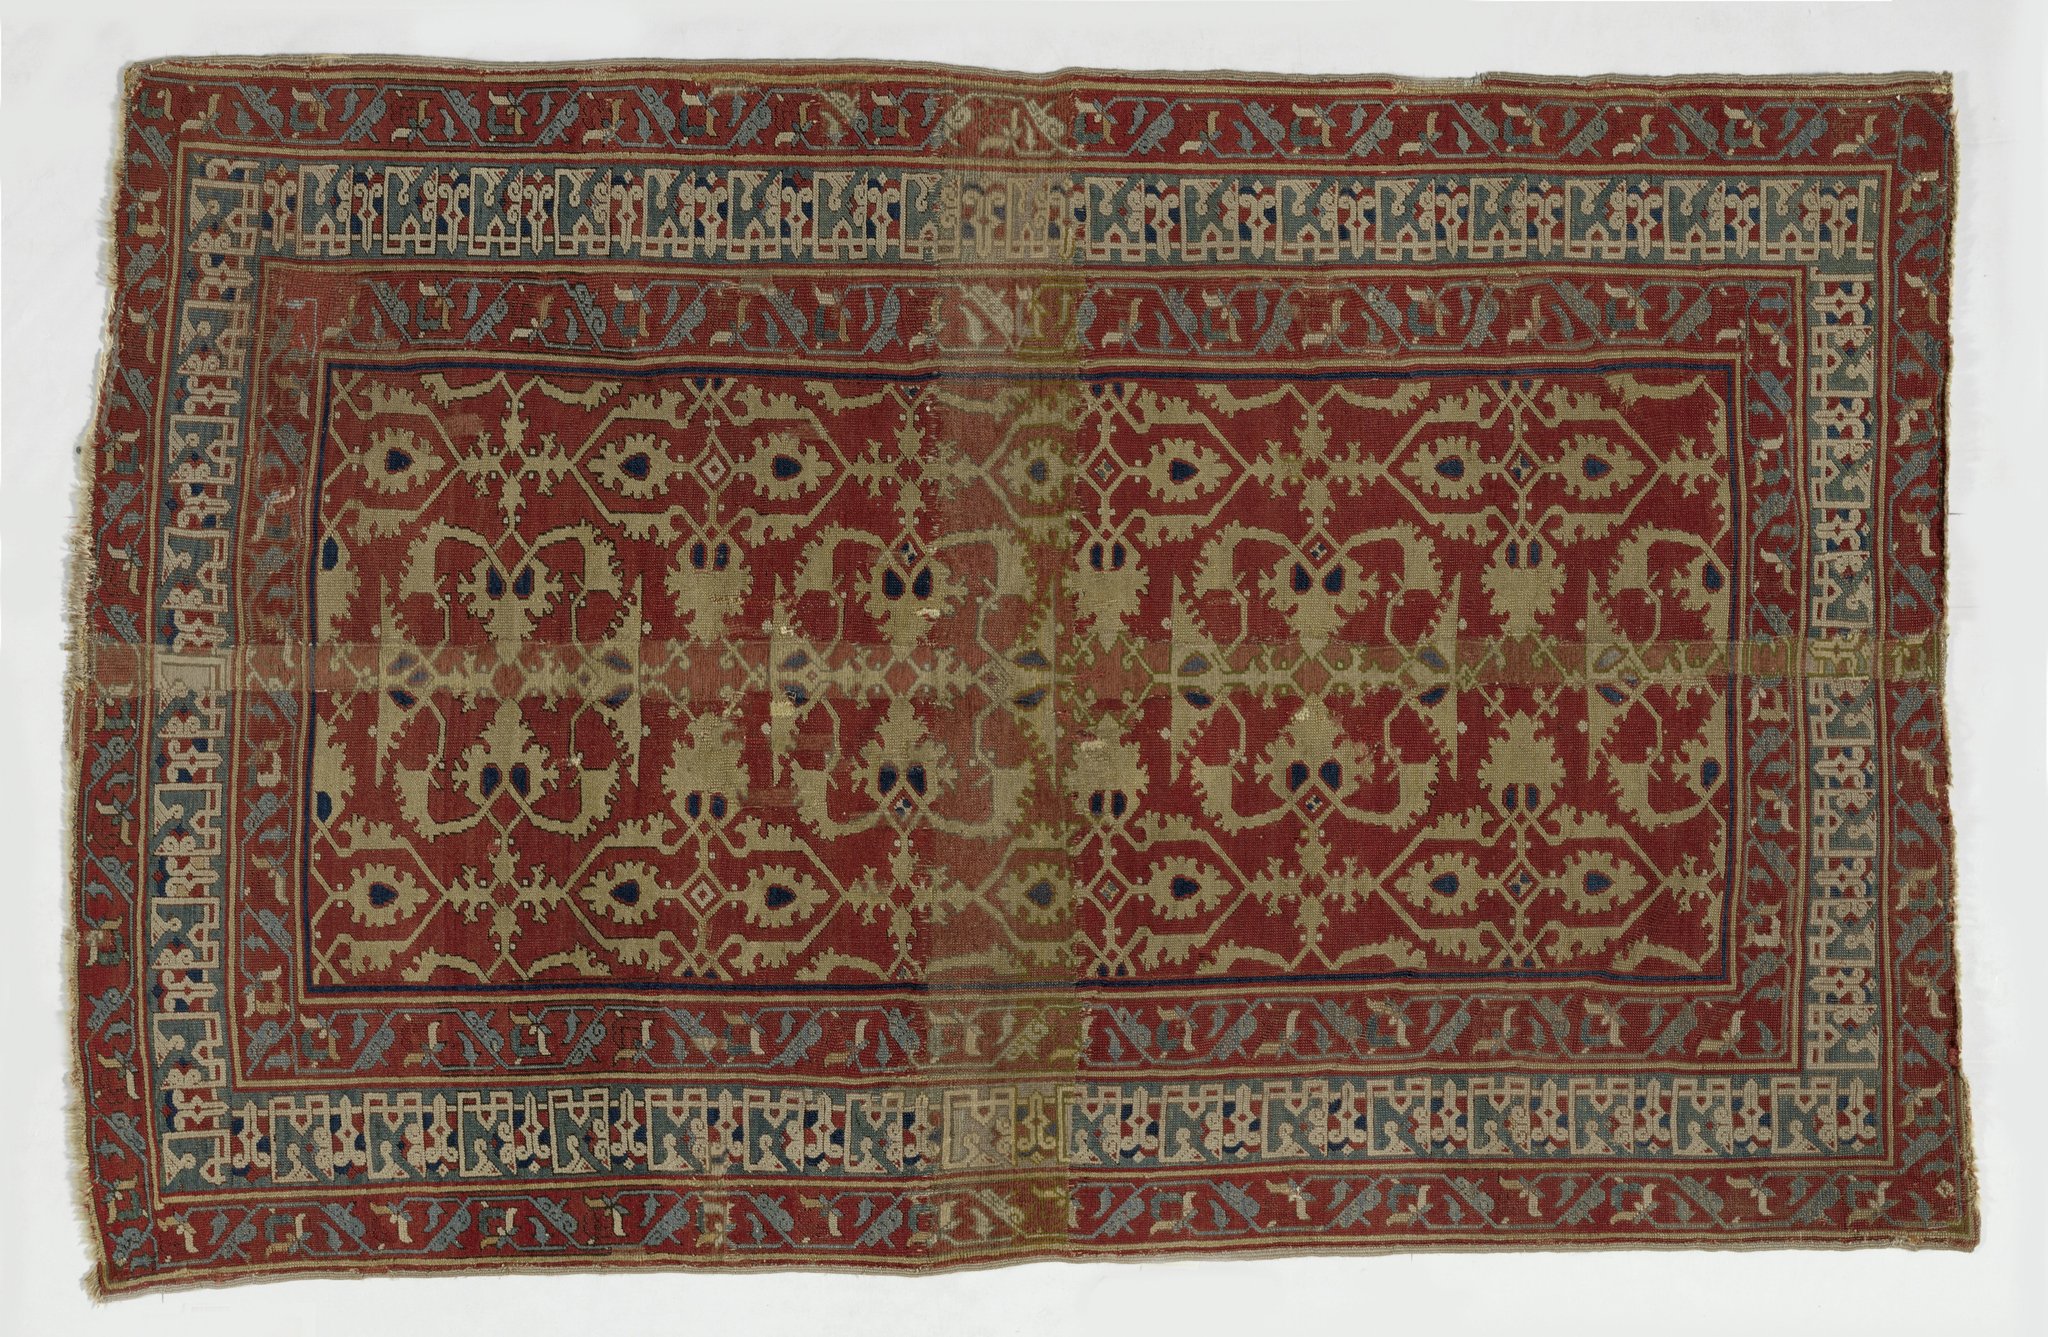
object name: fragment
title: Vier aan elkaar gezette fragmenten van een oosters tapijt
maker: Anonymous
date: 1500-1550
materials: wool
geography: turkey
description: Oosters tapijt, arabeskenkleed, lottotapijt. Vier fragmenten van wat oorspronkelijk een groter tapijt is geweest. In het middenveld een patroon van vloeiende lijnen en soepel weergegeven bladmotieven. De middelste rand is versierd met Kufische oramenten.